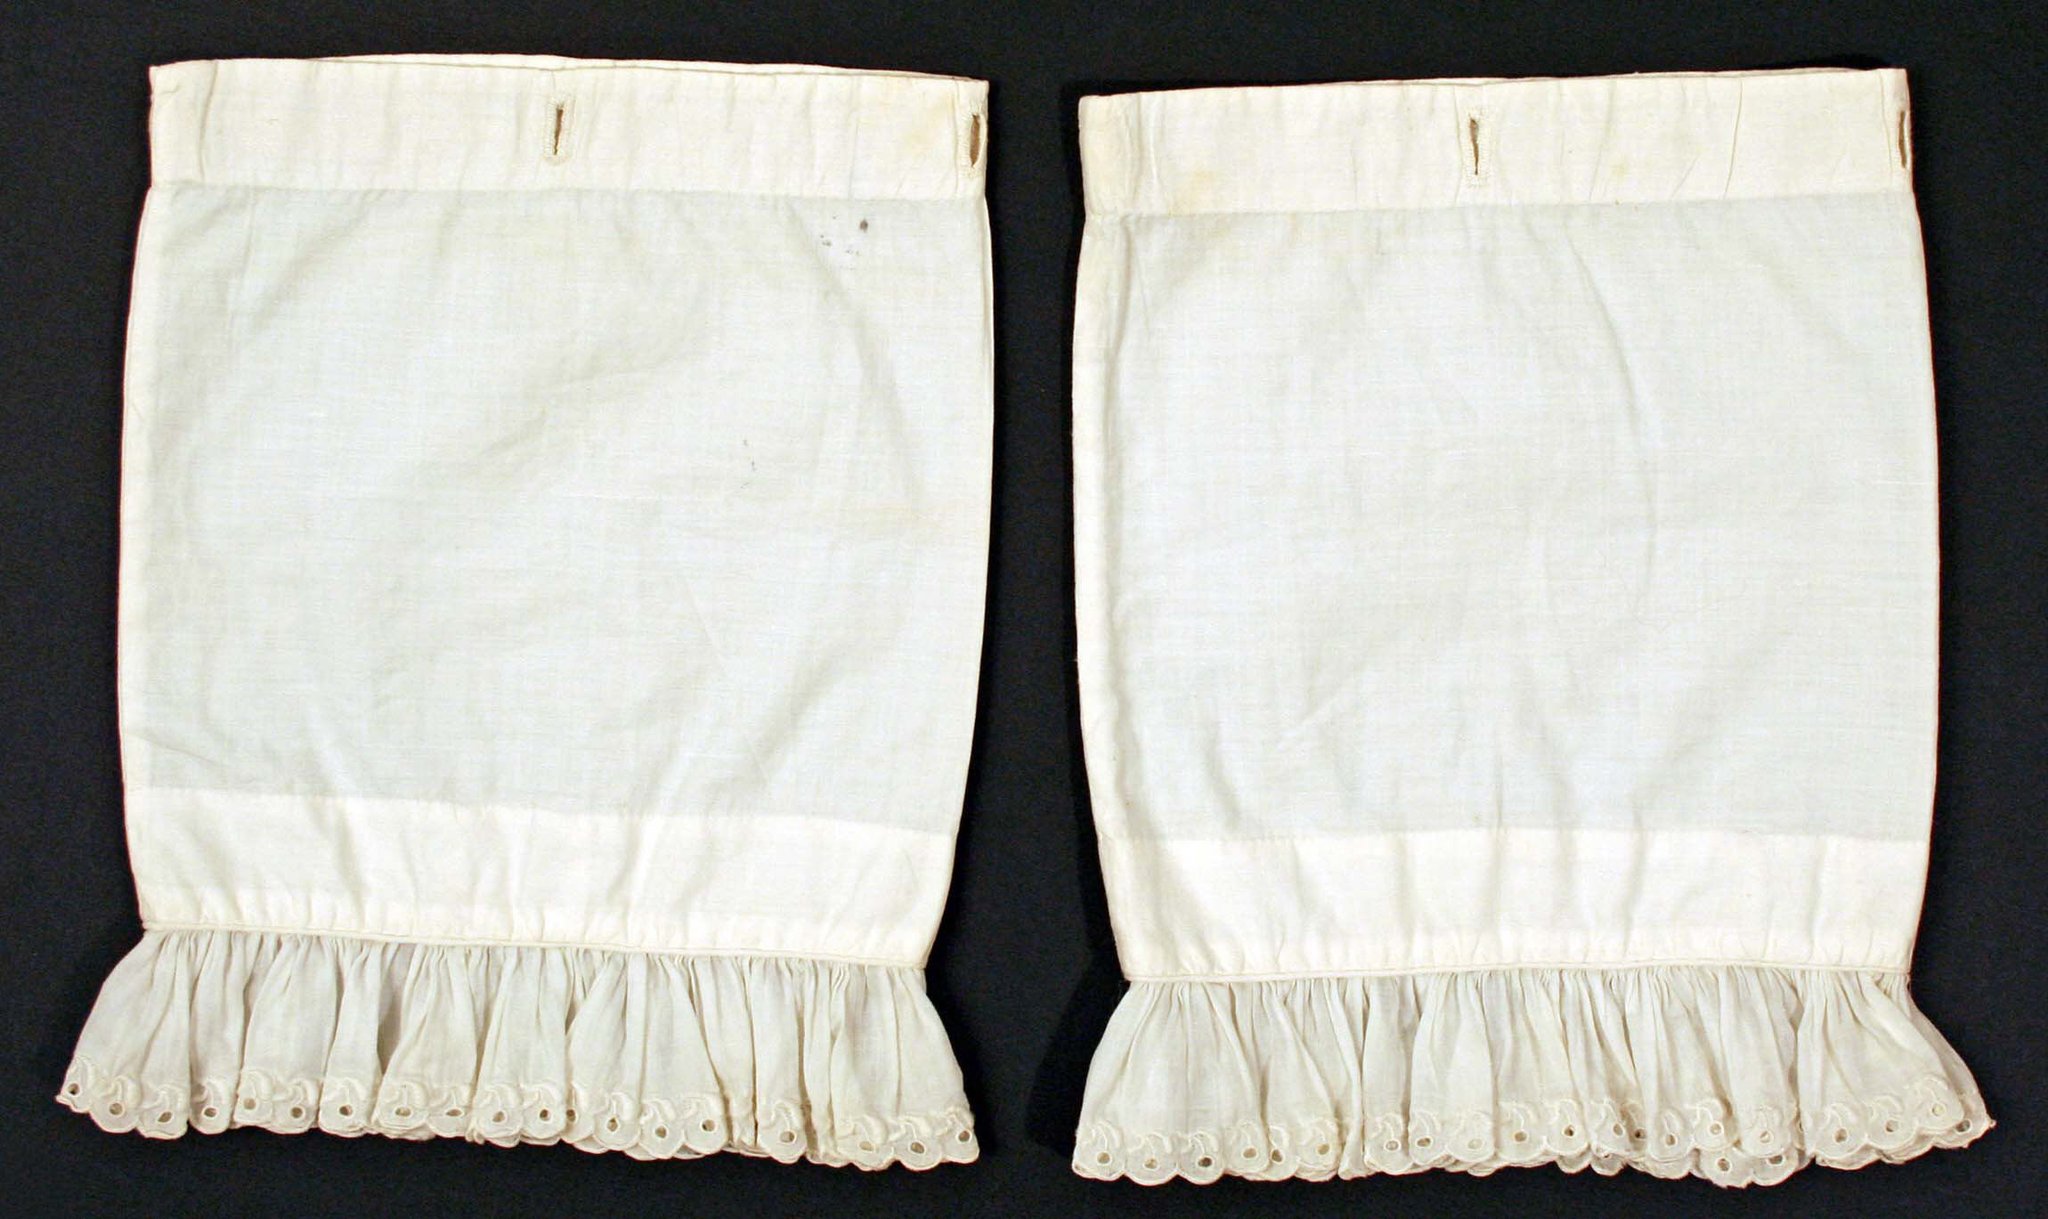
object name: pantalets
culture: american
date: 1838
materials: cotton